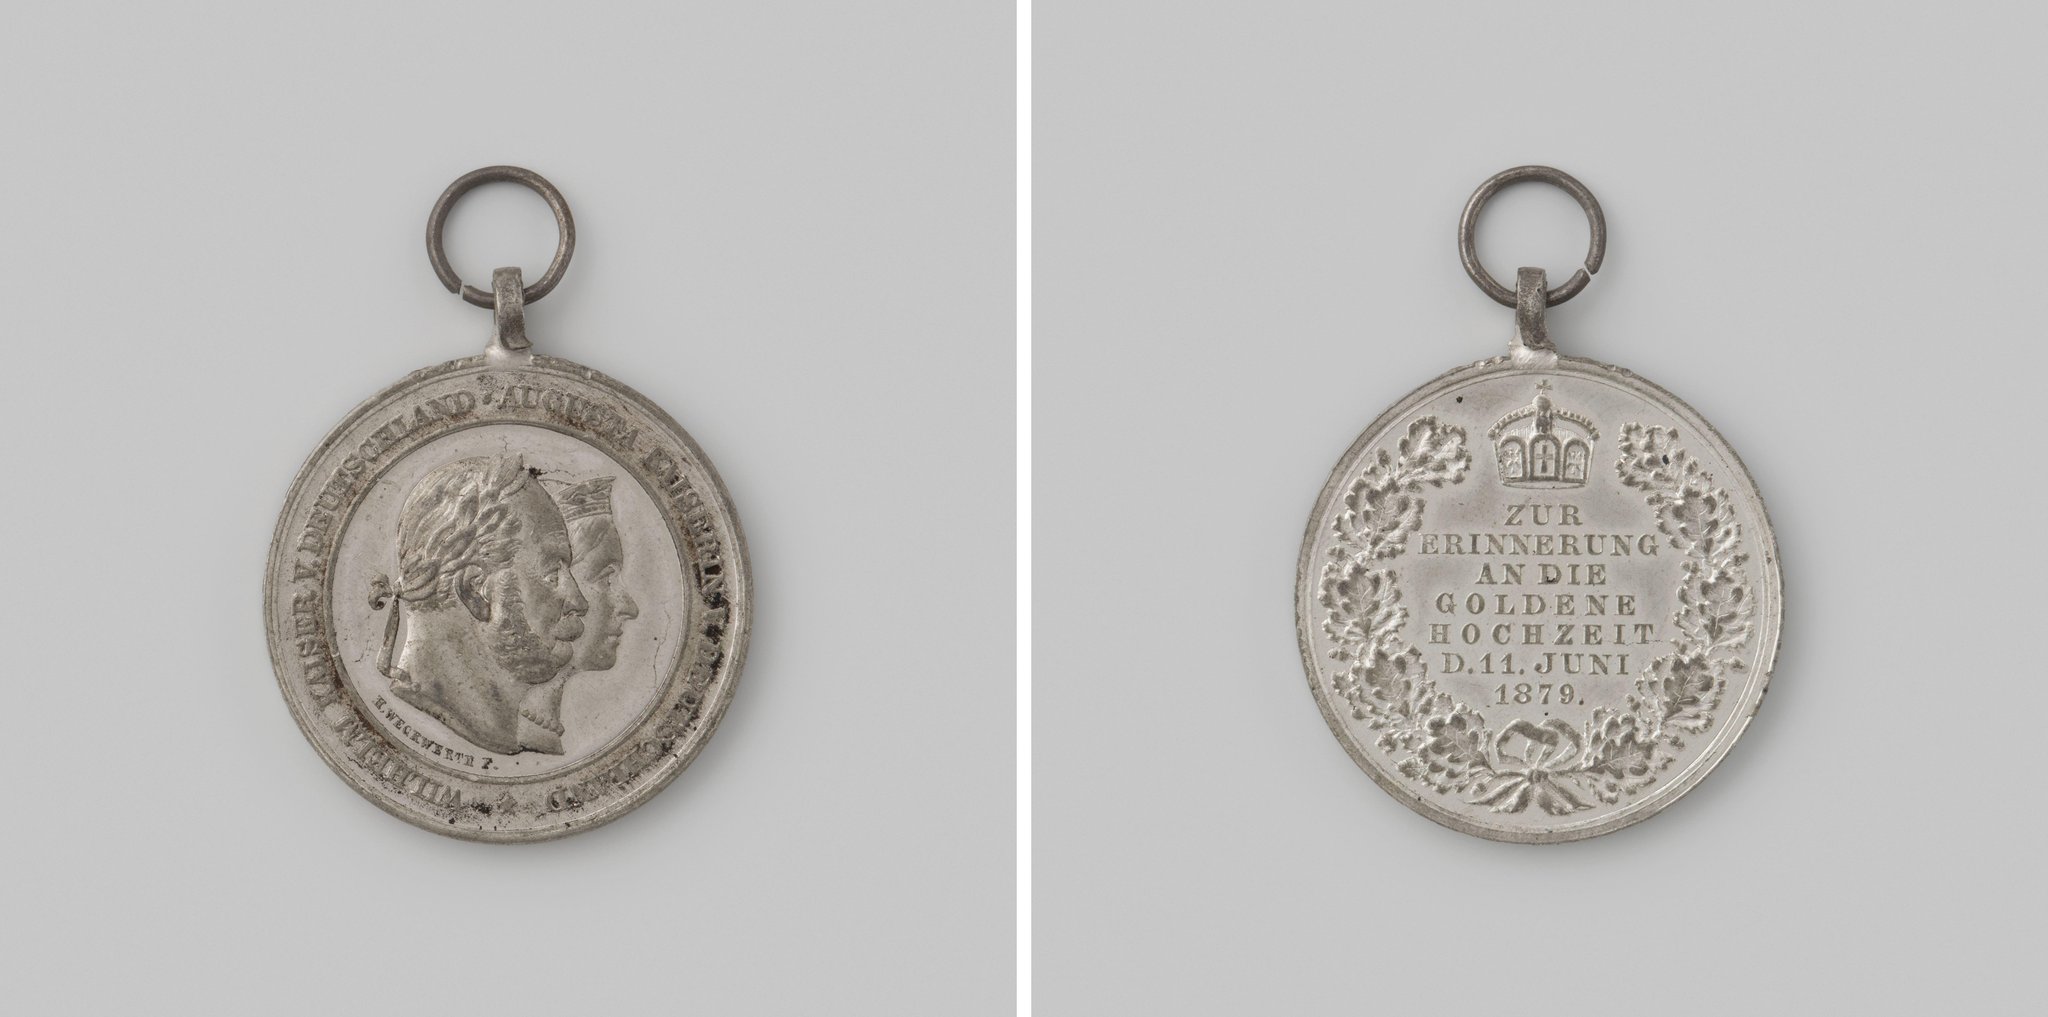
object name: history medal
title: Vijftigjarig huwelijk van Keizer Wilhelm I en Keizerin Augusta van Duitsland 1879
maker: h. weckwerth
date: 1879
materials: tin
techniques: striking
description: Tinnen penning met oog en draagring, op de voorzijde de geconjugeerde portretten van Wilhelm en Augusta naar rechts met omschrift, op de keerzijde een kroon en zeven regels tekst tussen samengebonden eikentakken.